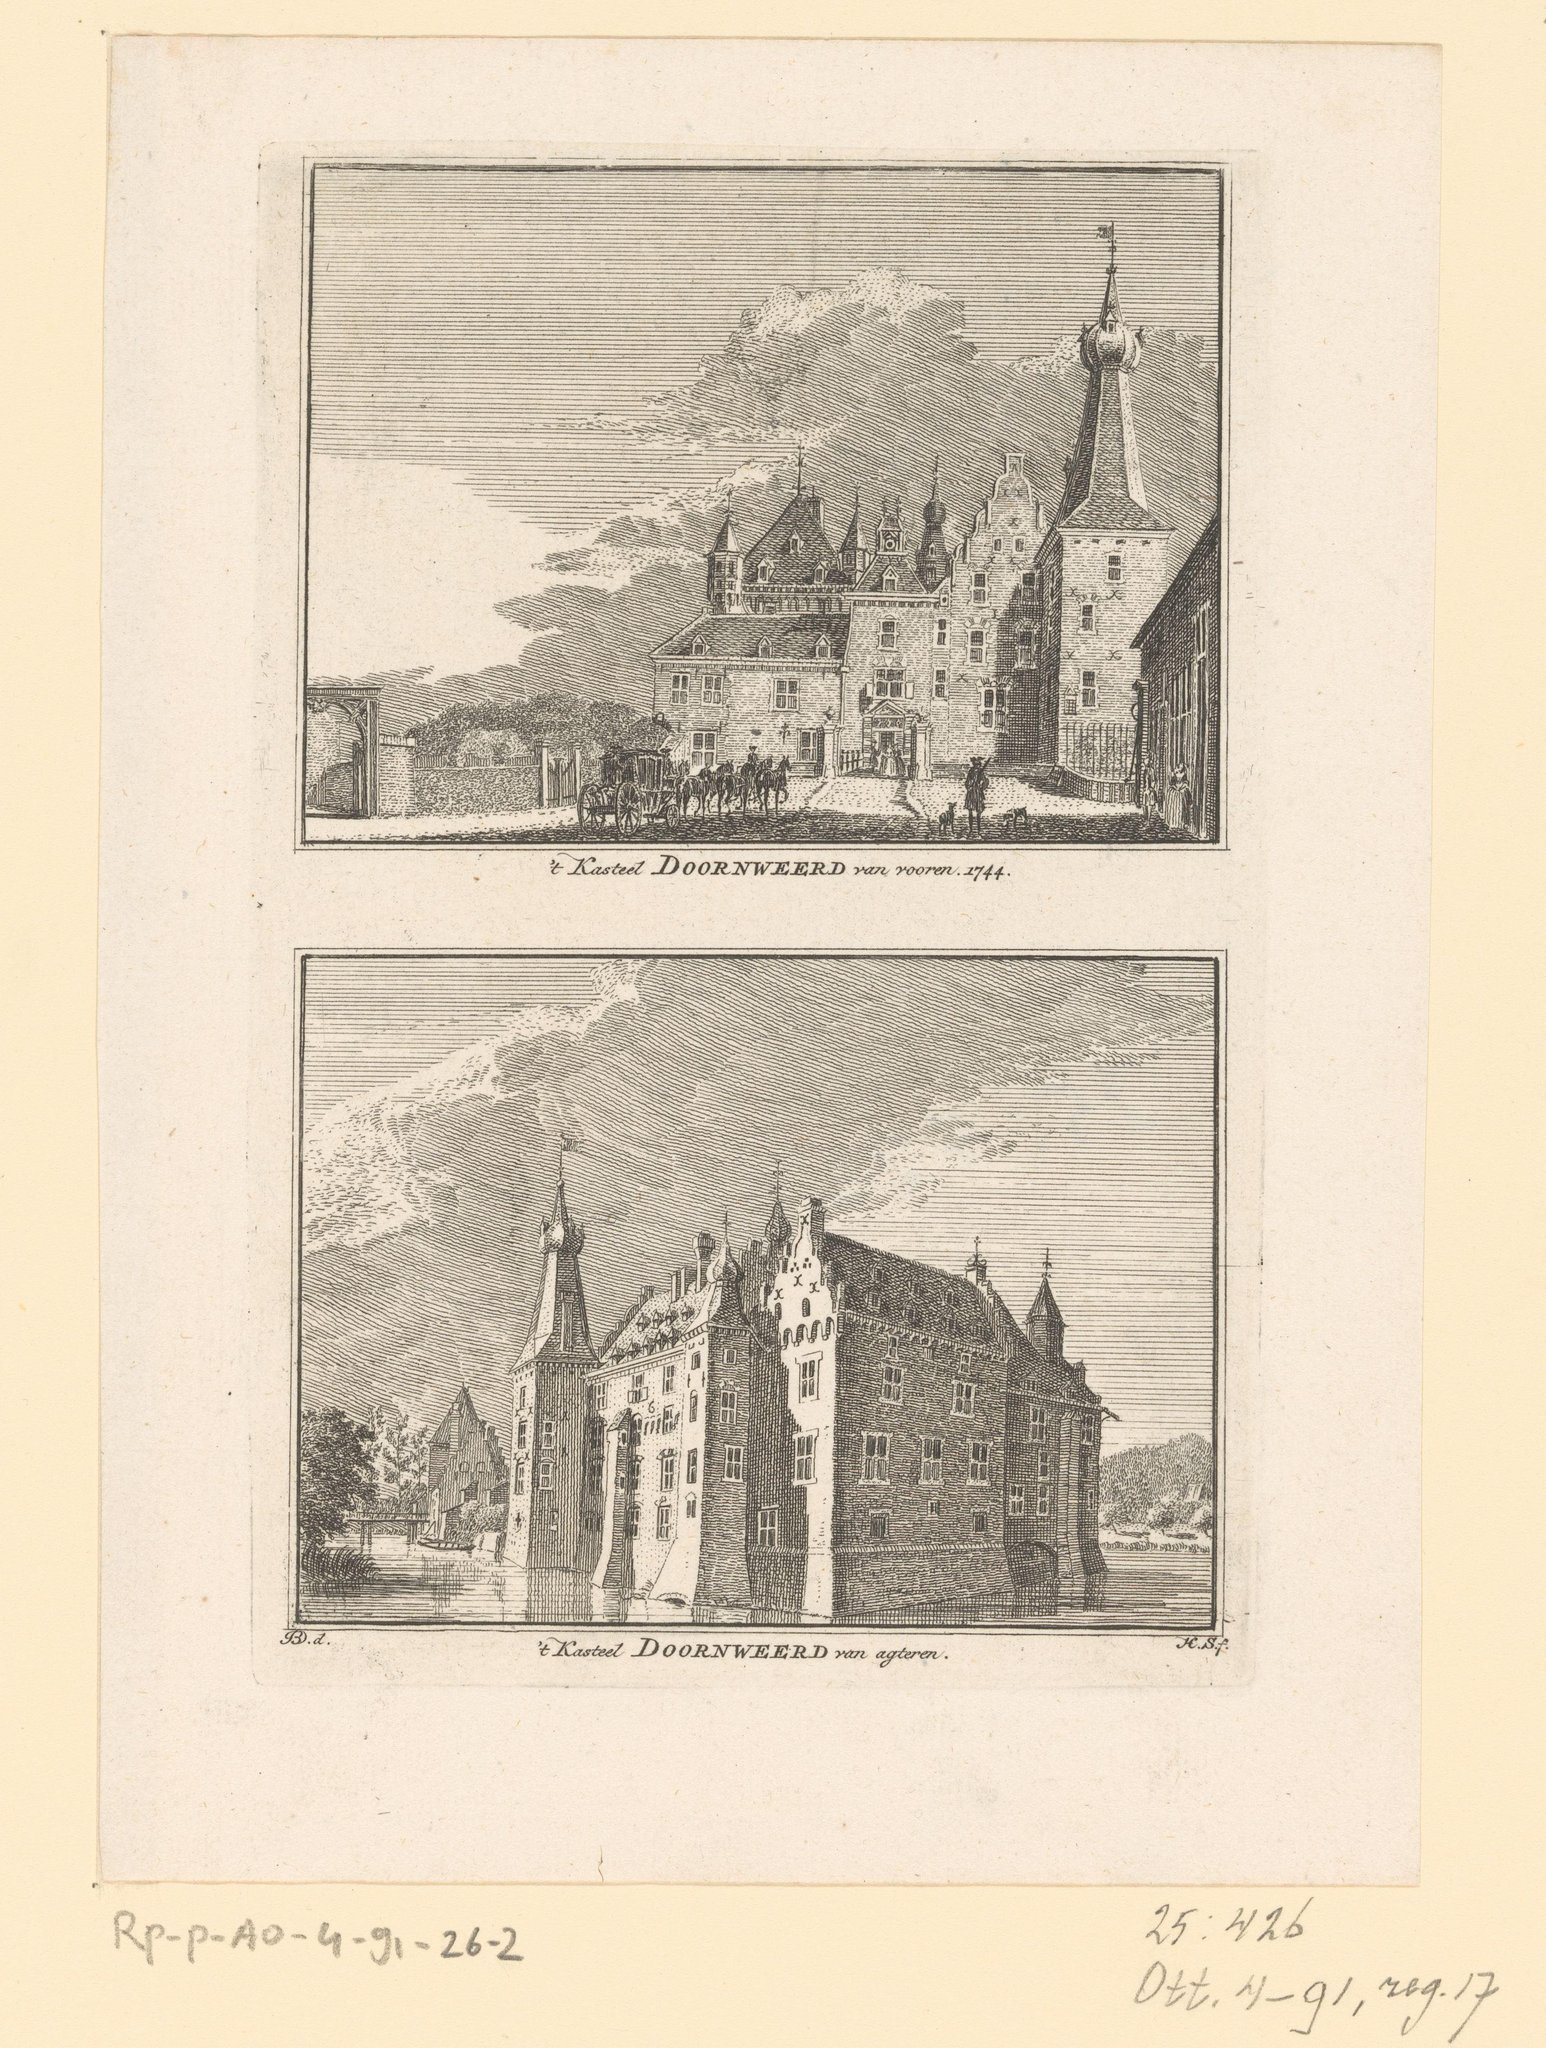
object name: print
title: 't Kasteel Doornweerd van vooren. 1744 / 't Kasteel Doornweer van agteren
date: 1745-1792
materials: paper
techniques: etching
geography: haarlem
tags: castle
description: Prent ook gebruikt in: Het verheerlykt Nederland of kabinet van hedendaagsche gezigten van steden, dorpen (…). 9 delen. Amsterdam: Isaak Tirion en weduwe Isaak Tirion, 1745-1774, dl. 1 (1745), ill. 95-96. Of in: Nederlandsche tafereelen; of eene keurige verzameling van negen honderd fraaije gezigten van steden, dorpen, sloten, oudheden (….). 9 delen. Amsterdam: Jan de Groot, 1792, dl. 1, ill. 95-96.